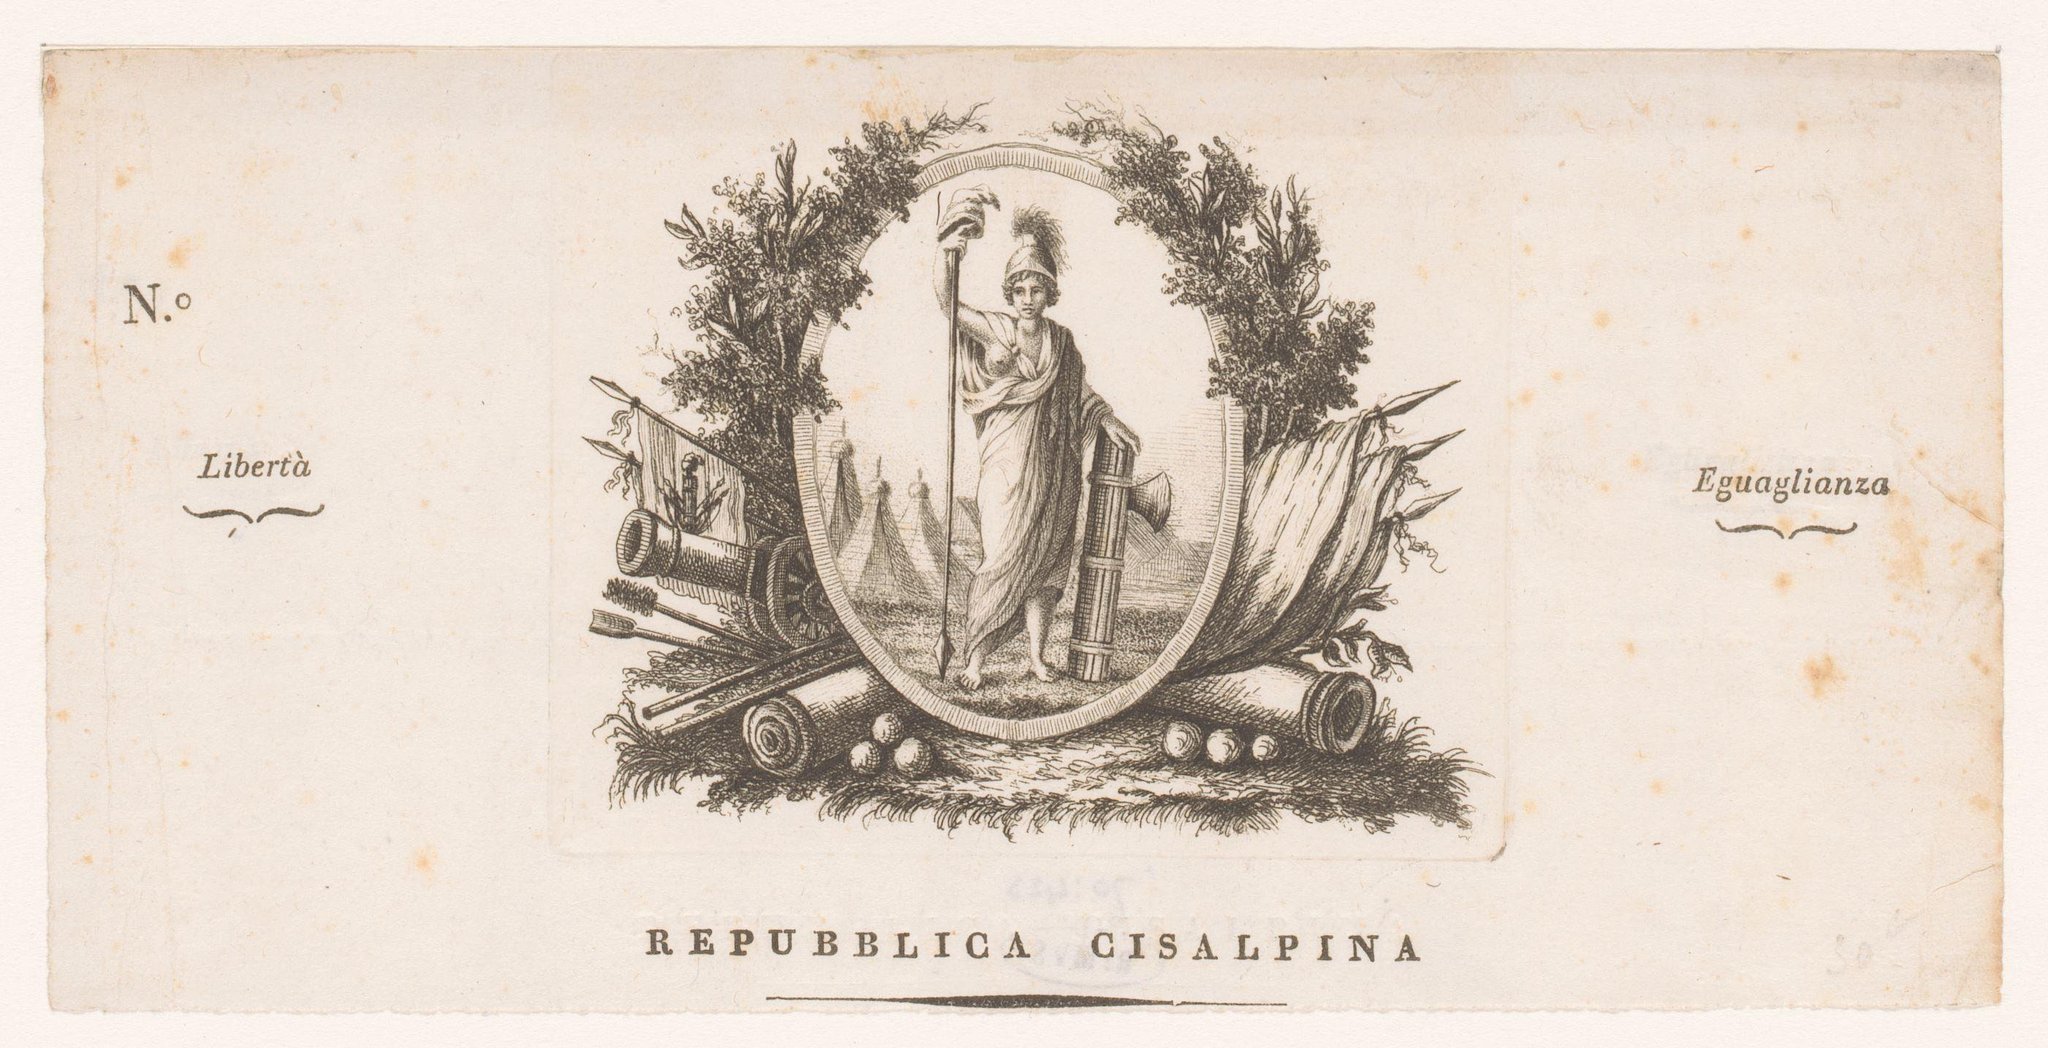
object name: print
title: Repubblica Cisalpina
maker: Anonymous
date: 1797-1808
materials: paper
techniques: etching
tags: governmental and representative bodies, phrygian bonnet, letter, envelope, freedom, liberty; 'libertà' (ripa)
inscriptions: collector's mark: Lugt 2228